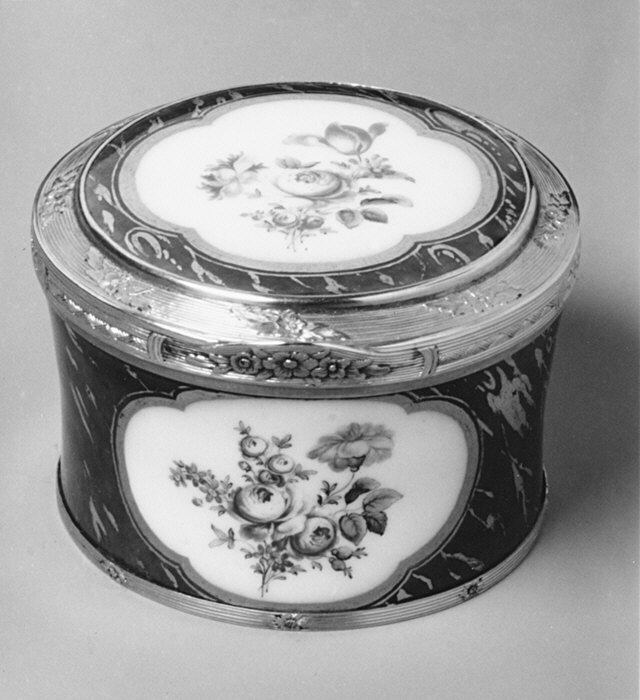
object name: snuffbox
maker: imperial porcelain manufactory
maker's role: manufactory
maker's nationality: austrian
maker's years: 1744-1864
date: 1765-1770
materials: gold, hard paste porcelain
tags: flowers